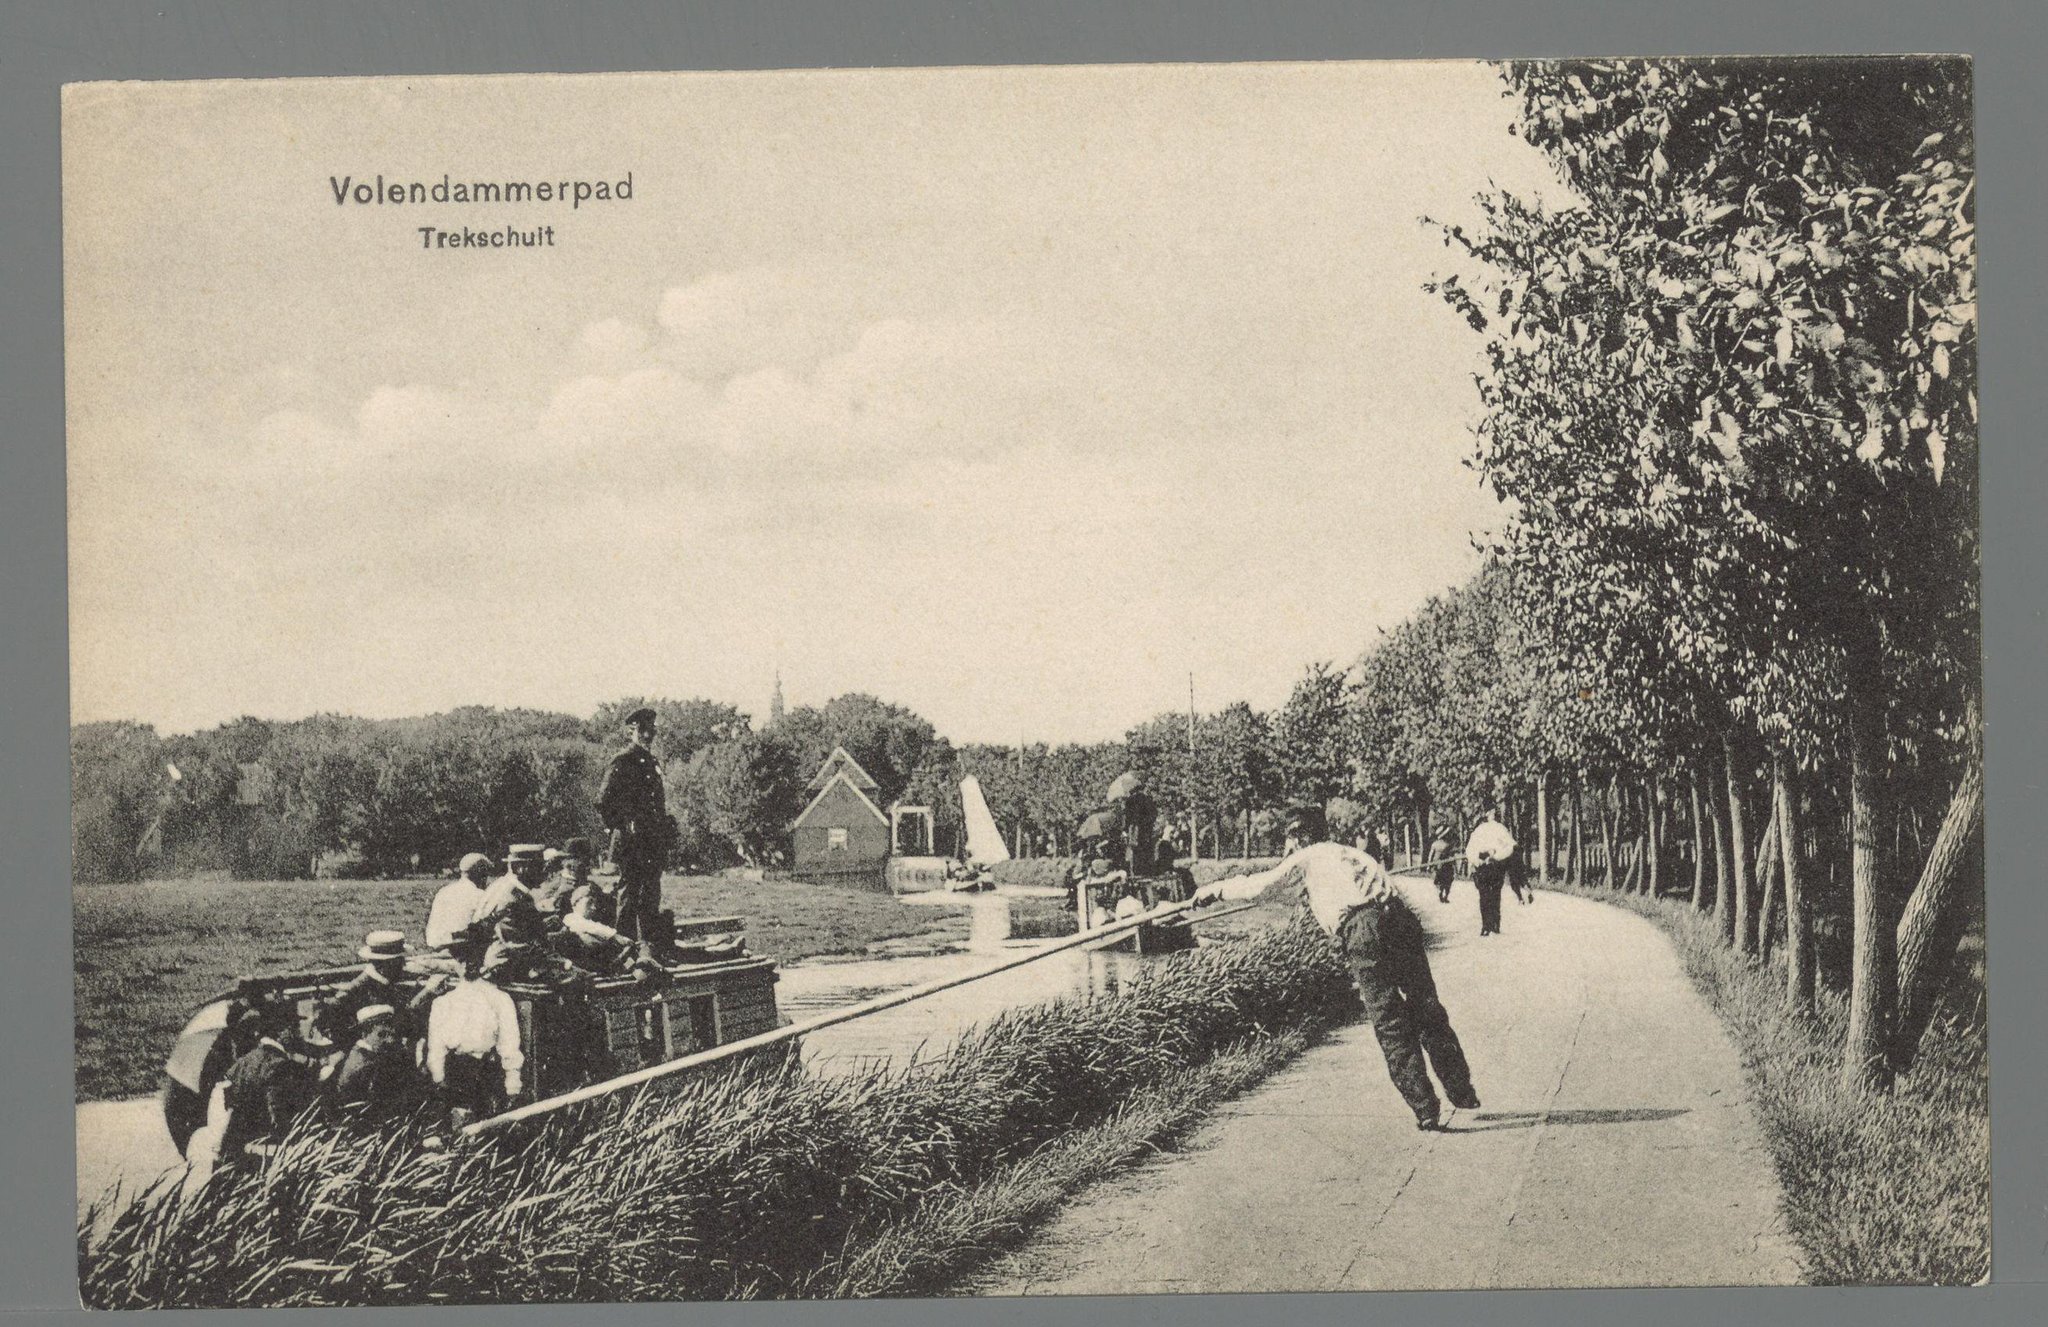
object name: photomechanical print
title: Volendammerpad. Trekschuit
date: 1906-1908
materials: cardboard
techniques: photograph, writing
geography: volendam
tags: canal, tow-boat, towing-barge